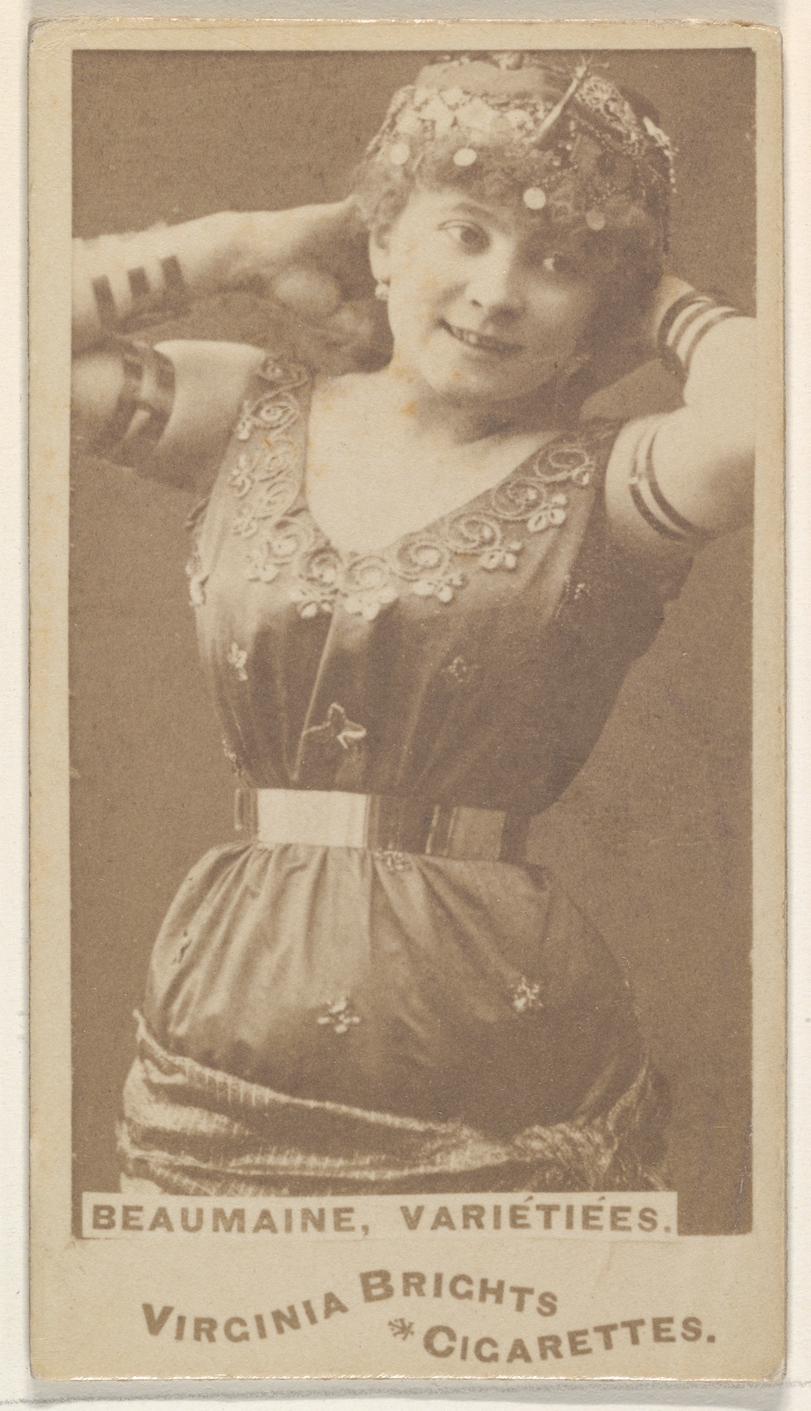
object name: photograph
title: Beaumaine, Varietiees, from the Actors and Actresses series (N45, Type 1) for Virginia Brights Cigarettes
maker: allen & ginter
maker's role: publisher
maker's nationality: american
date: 1888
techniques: albumen silver print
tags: portraits,women,actresses